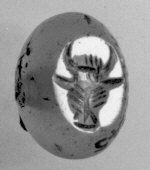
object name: stamp seal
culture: sasanian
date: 201-700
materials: stone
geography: iran or mesopotamia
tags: animals